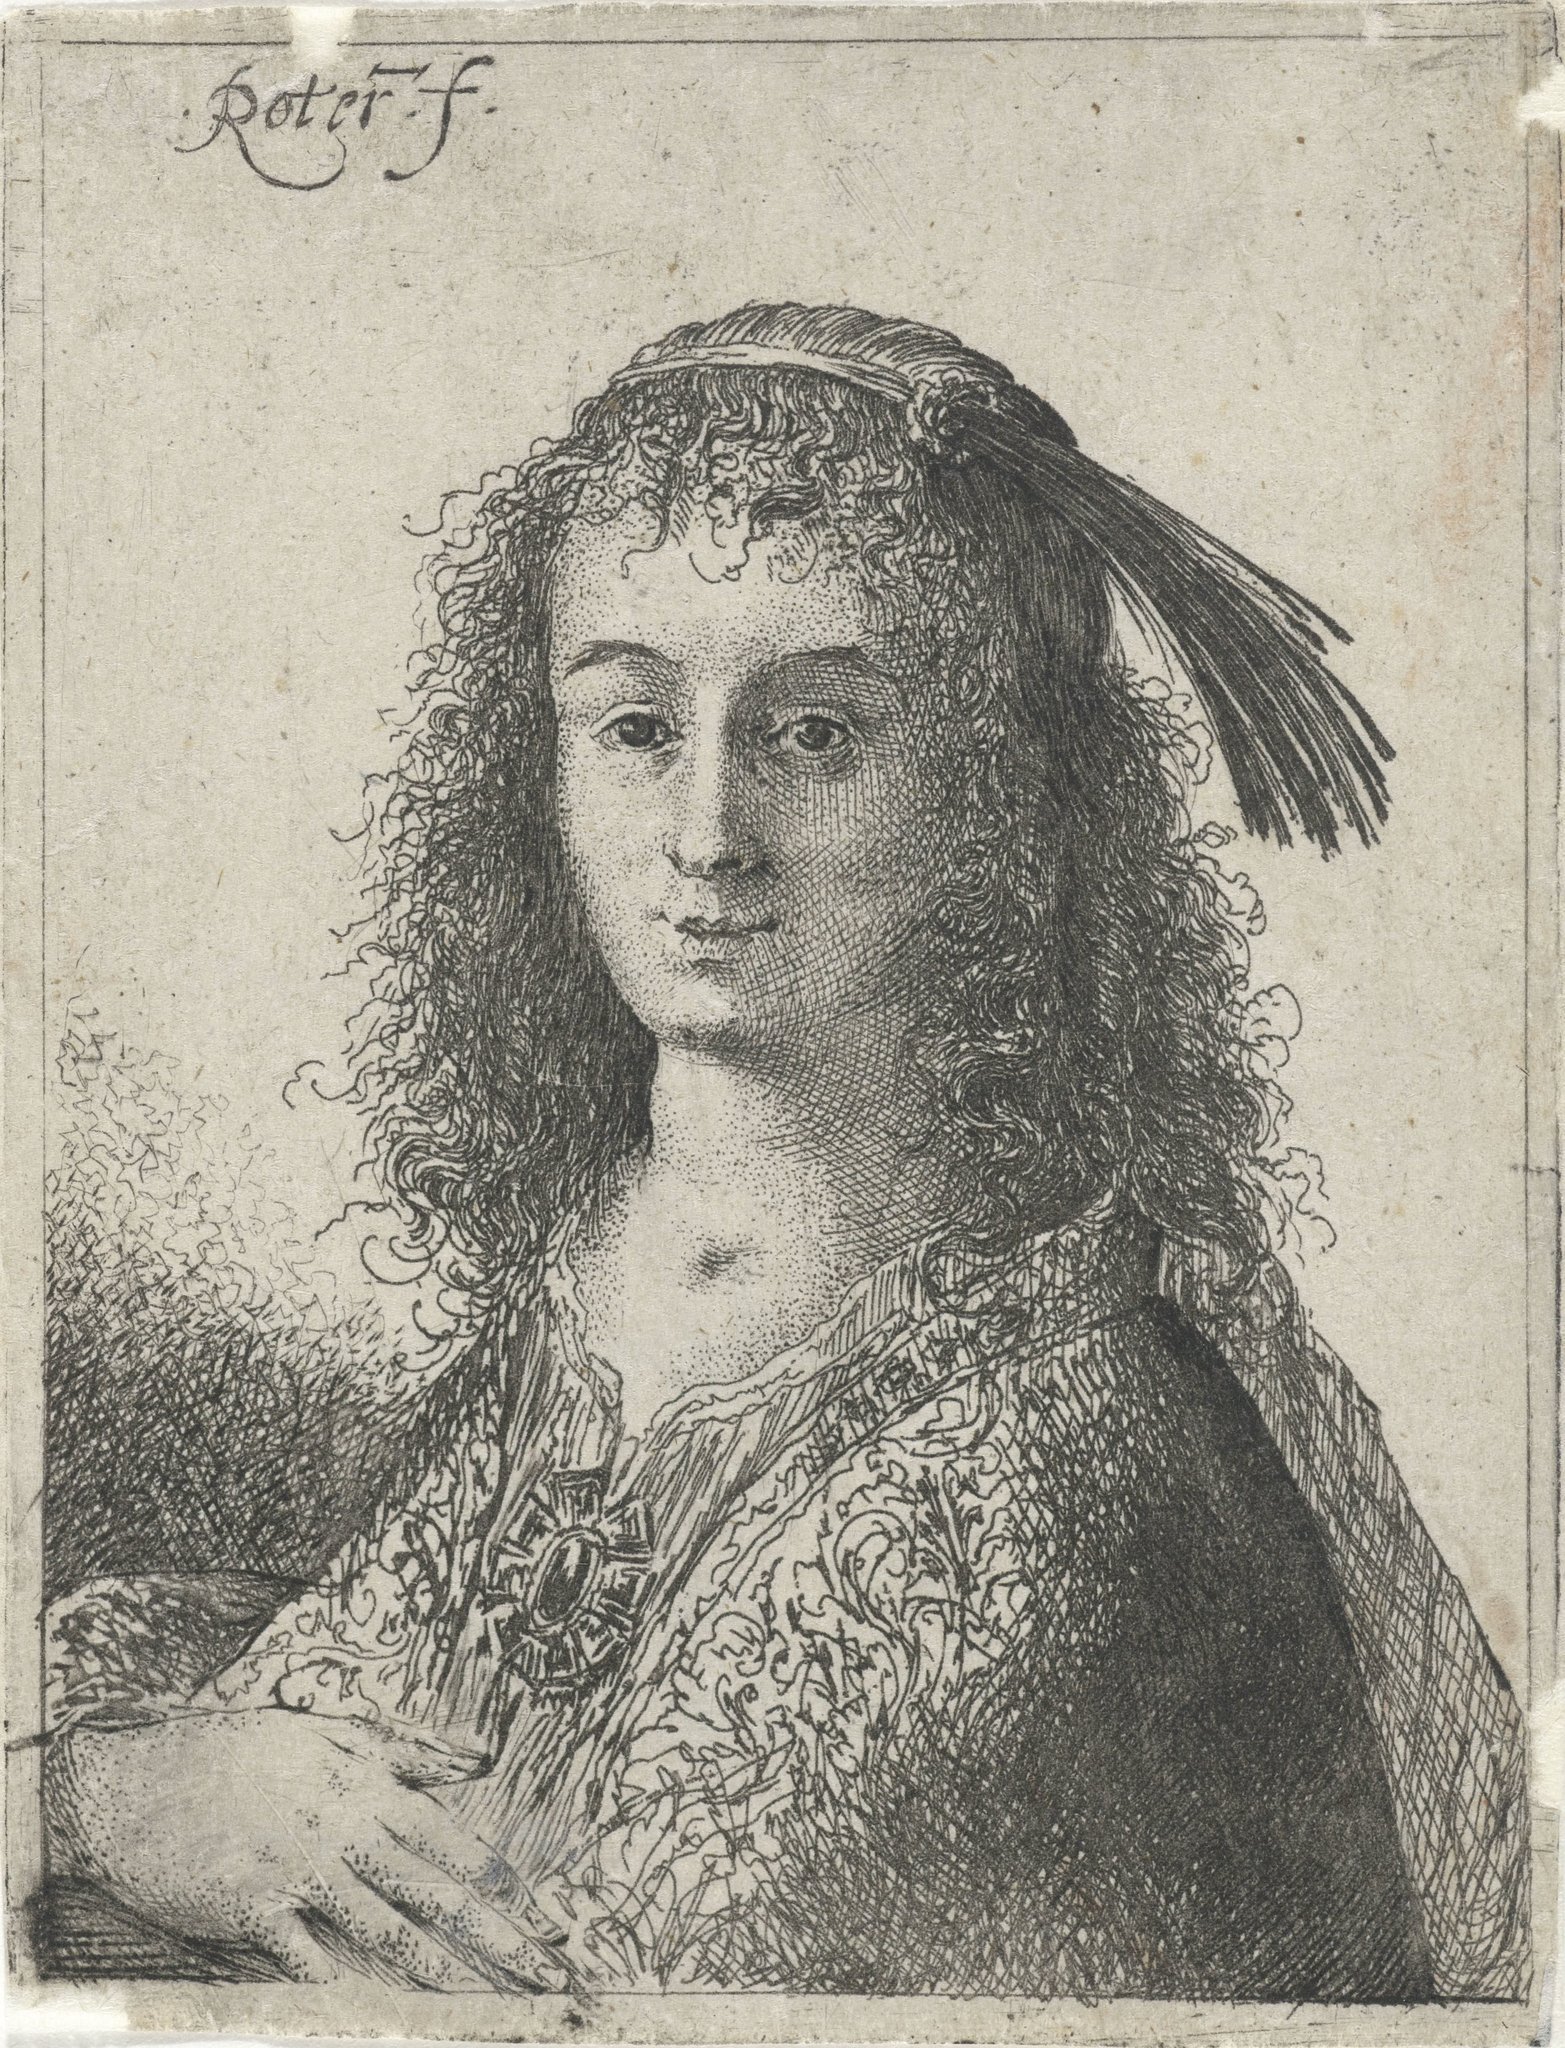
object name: print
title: Buste van een jonge vrouw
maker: pieter rottermondt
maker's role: draughtsman, print maker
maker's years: -1706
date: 1639-1706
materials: paper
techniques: engraving, etching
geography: northern netherlands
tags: head-gear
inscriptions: collector's mark: Lugt 240